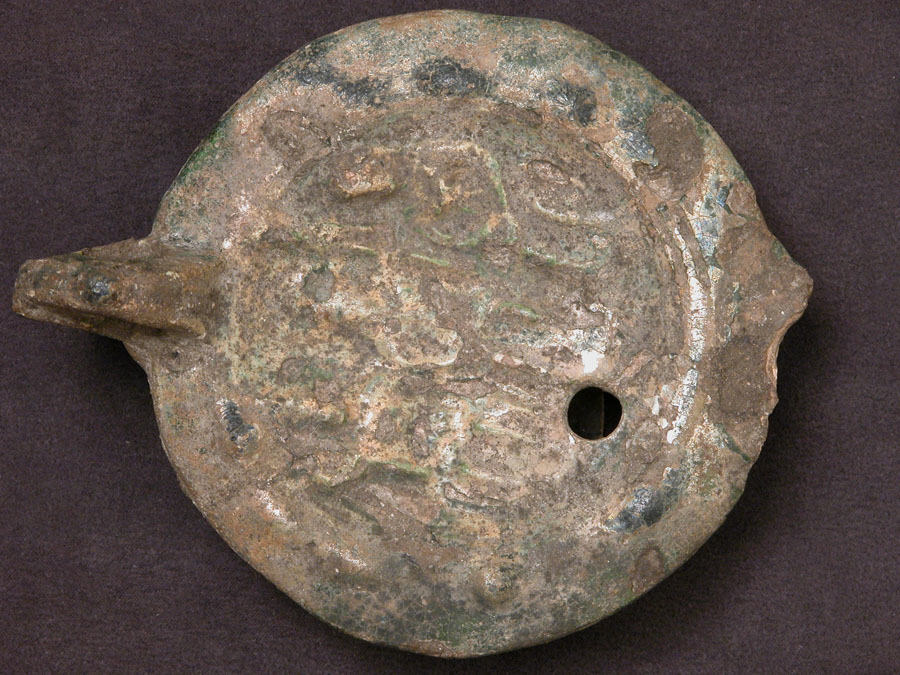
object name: lamp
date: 1-200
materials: earthenware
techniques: glazing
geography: syria